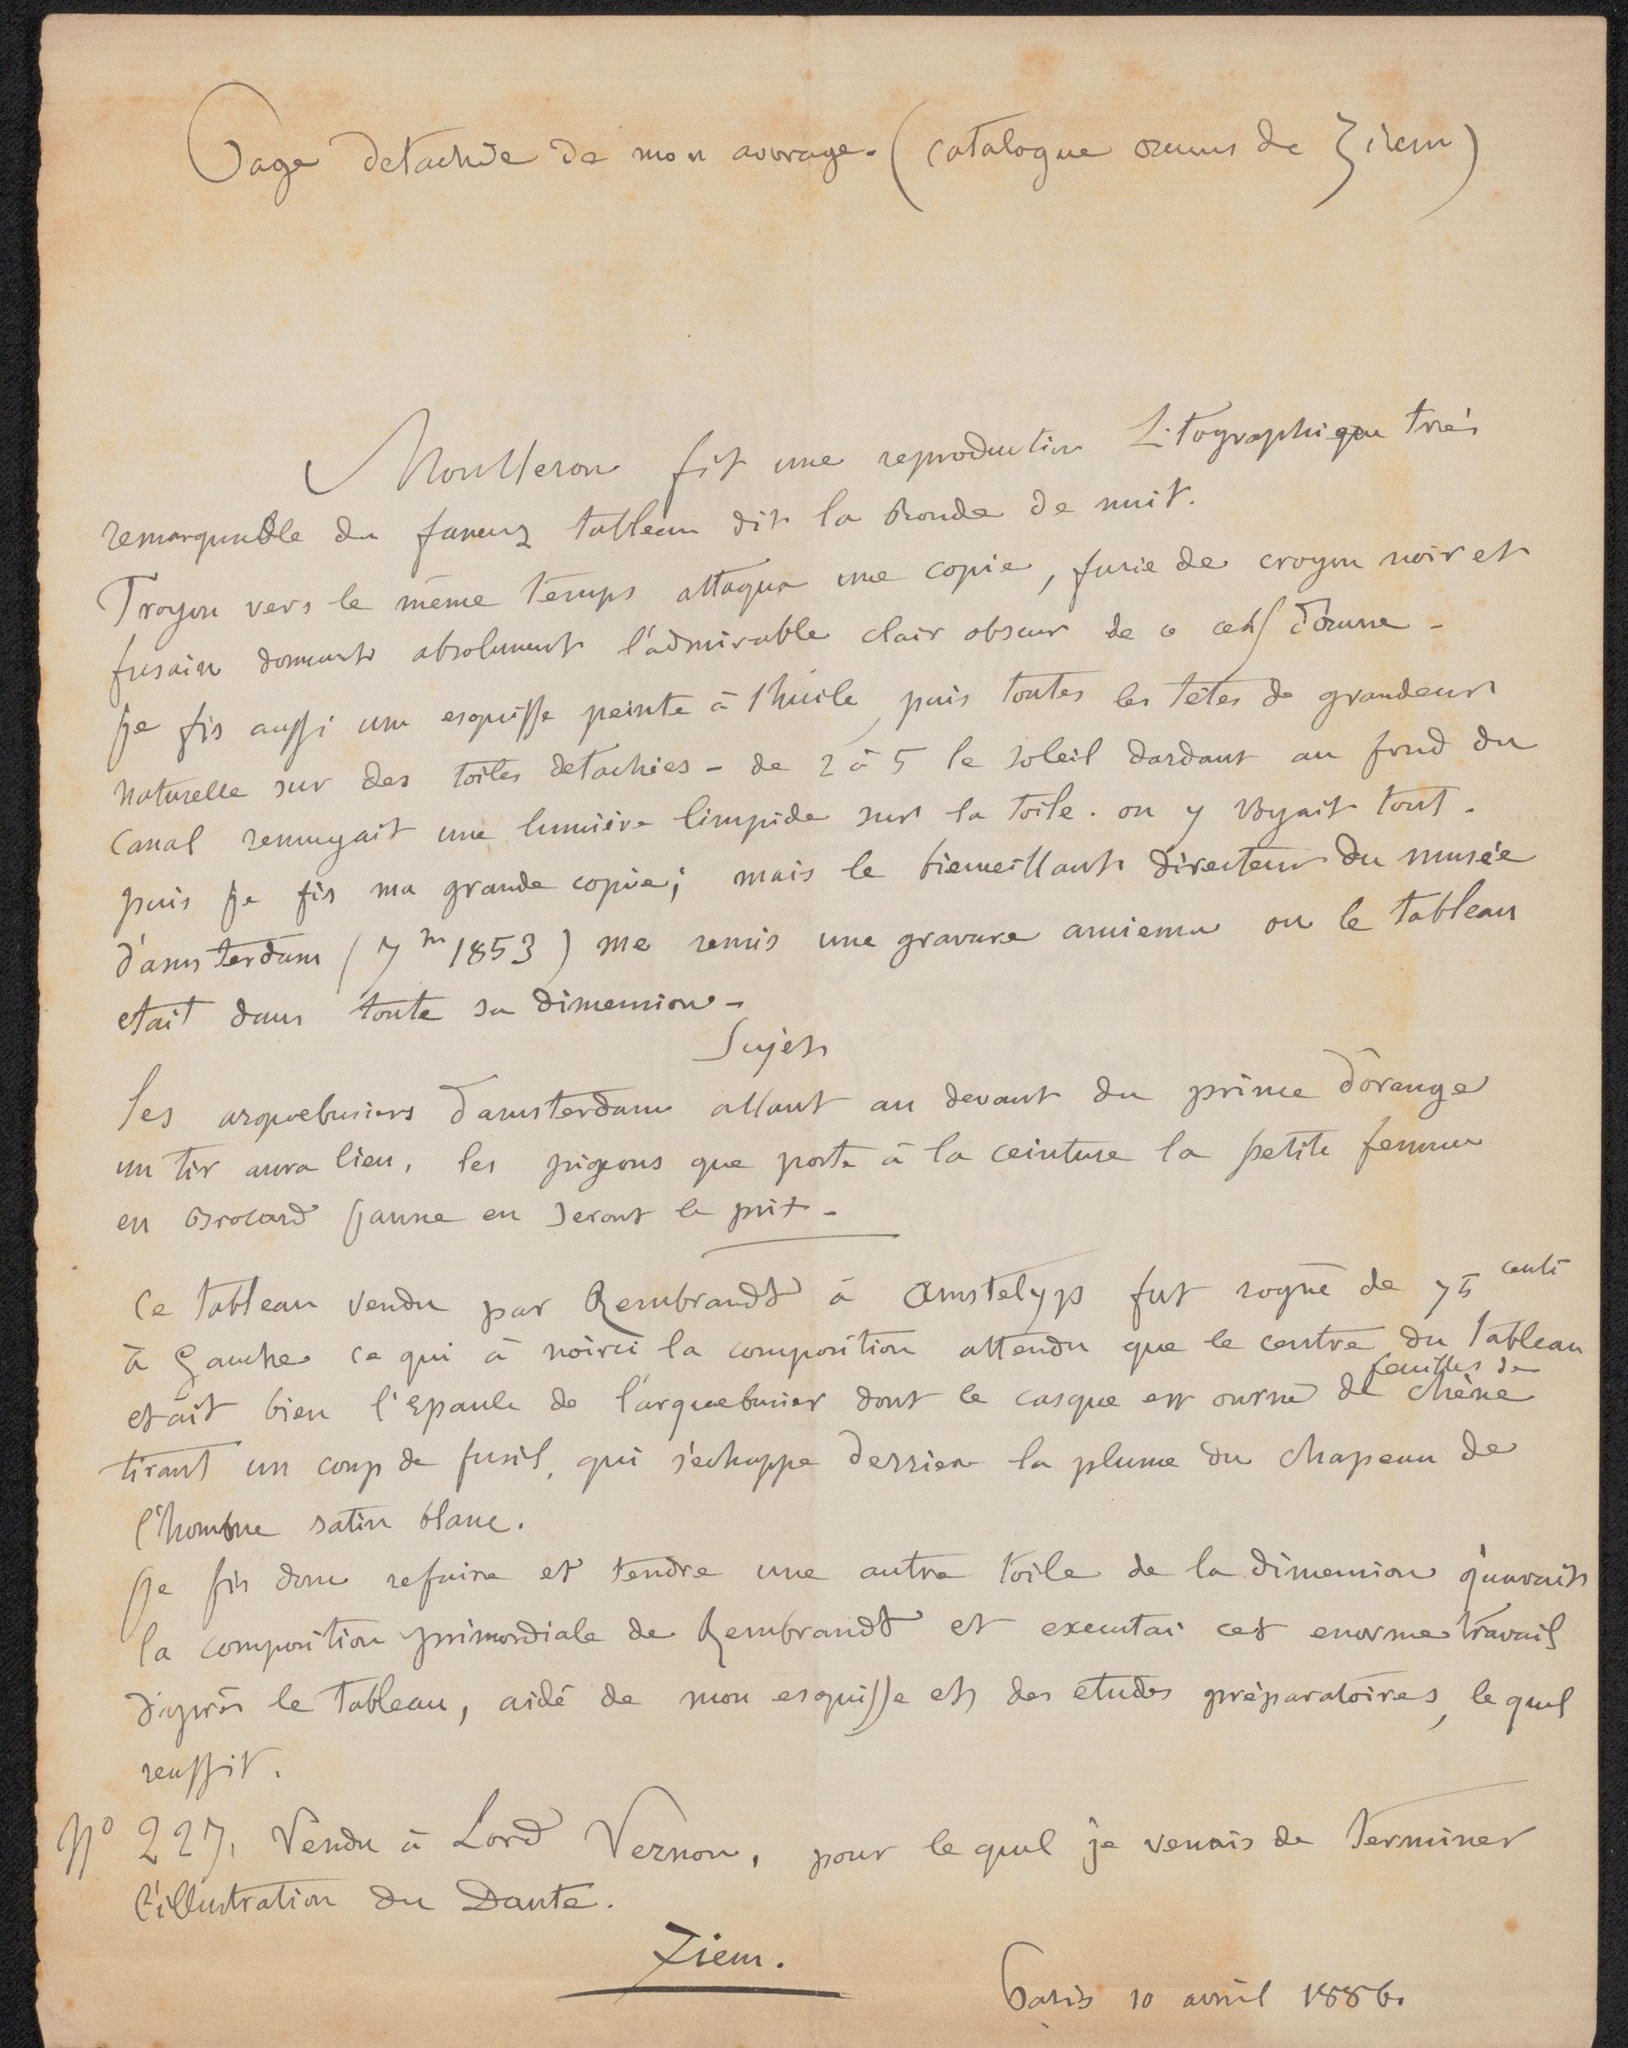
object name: tekst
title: Verslag over het kopiëren van De Nachtwacht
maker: félix françois georges philibert ziem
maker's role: painter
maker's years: 1821-1911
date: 1886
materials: ink, paper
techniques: pen, writing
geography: paris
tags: leiden, draughtsman, rembrandt van rijn, rijksmuseum amsterdam, the graphic arts, painting (including book-illumination, miniature-painting)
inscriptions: collector's mark: Lugt 2228, watermark